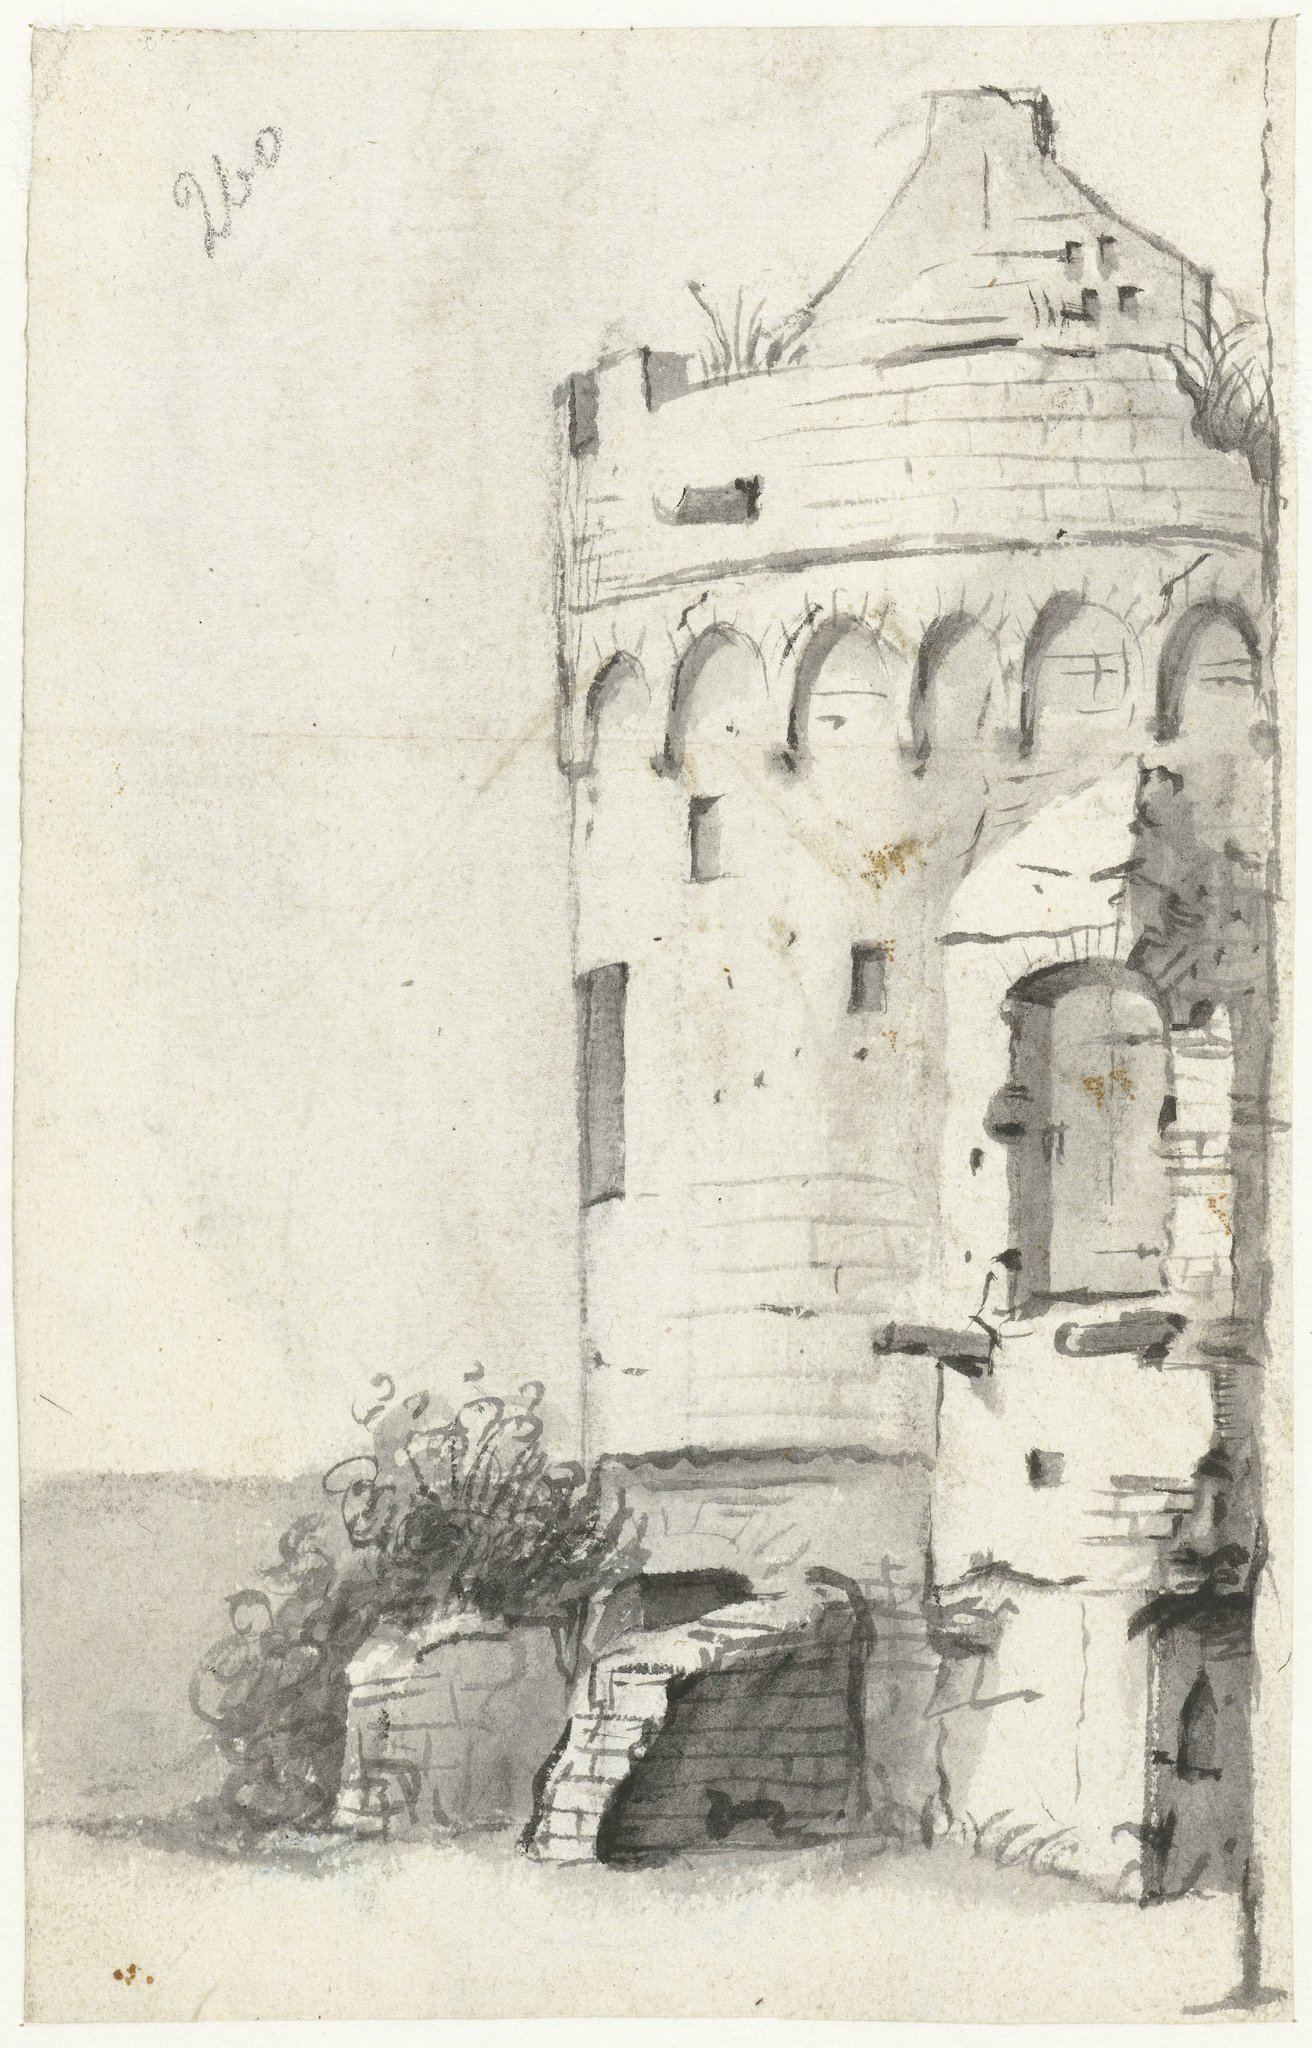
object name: drawing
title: Ruïne van een toren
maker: moses ter borch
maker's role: draughtsman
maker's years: 1645-1667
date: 1660-1661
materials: chalk, ink, paper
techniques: brush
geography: hattem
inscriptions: name: ‘Mosus ter Borch’